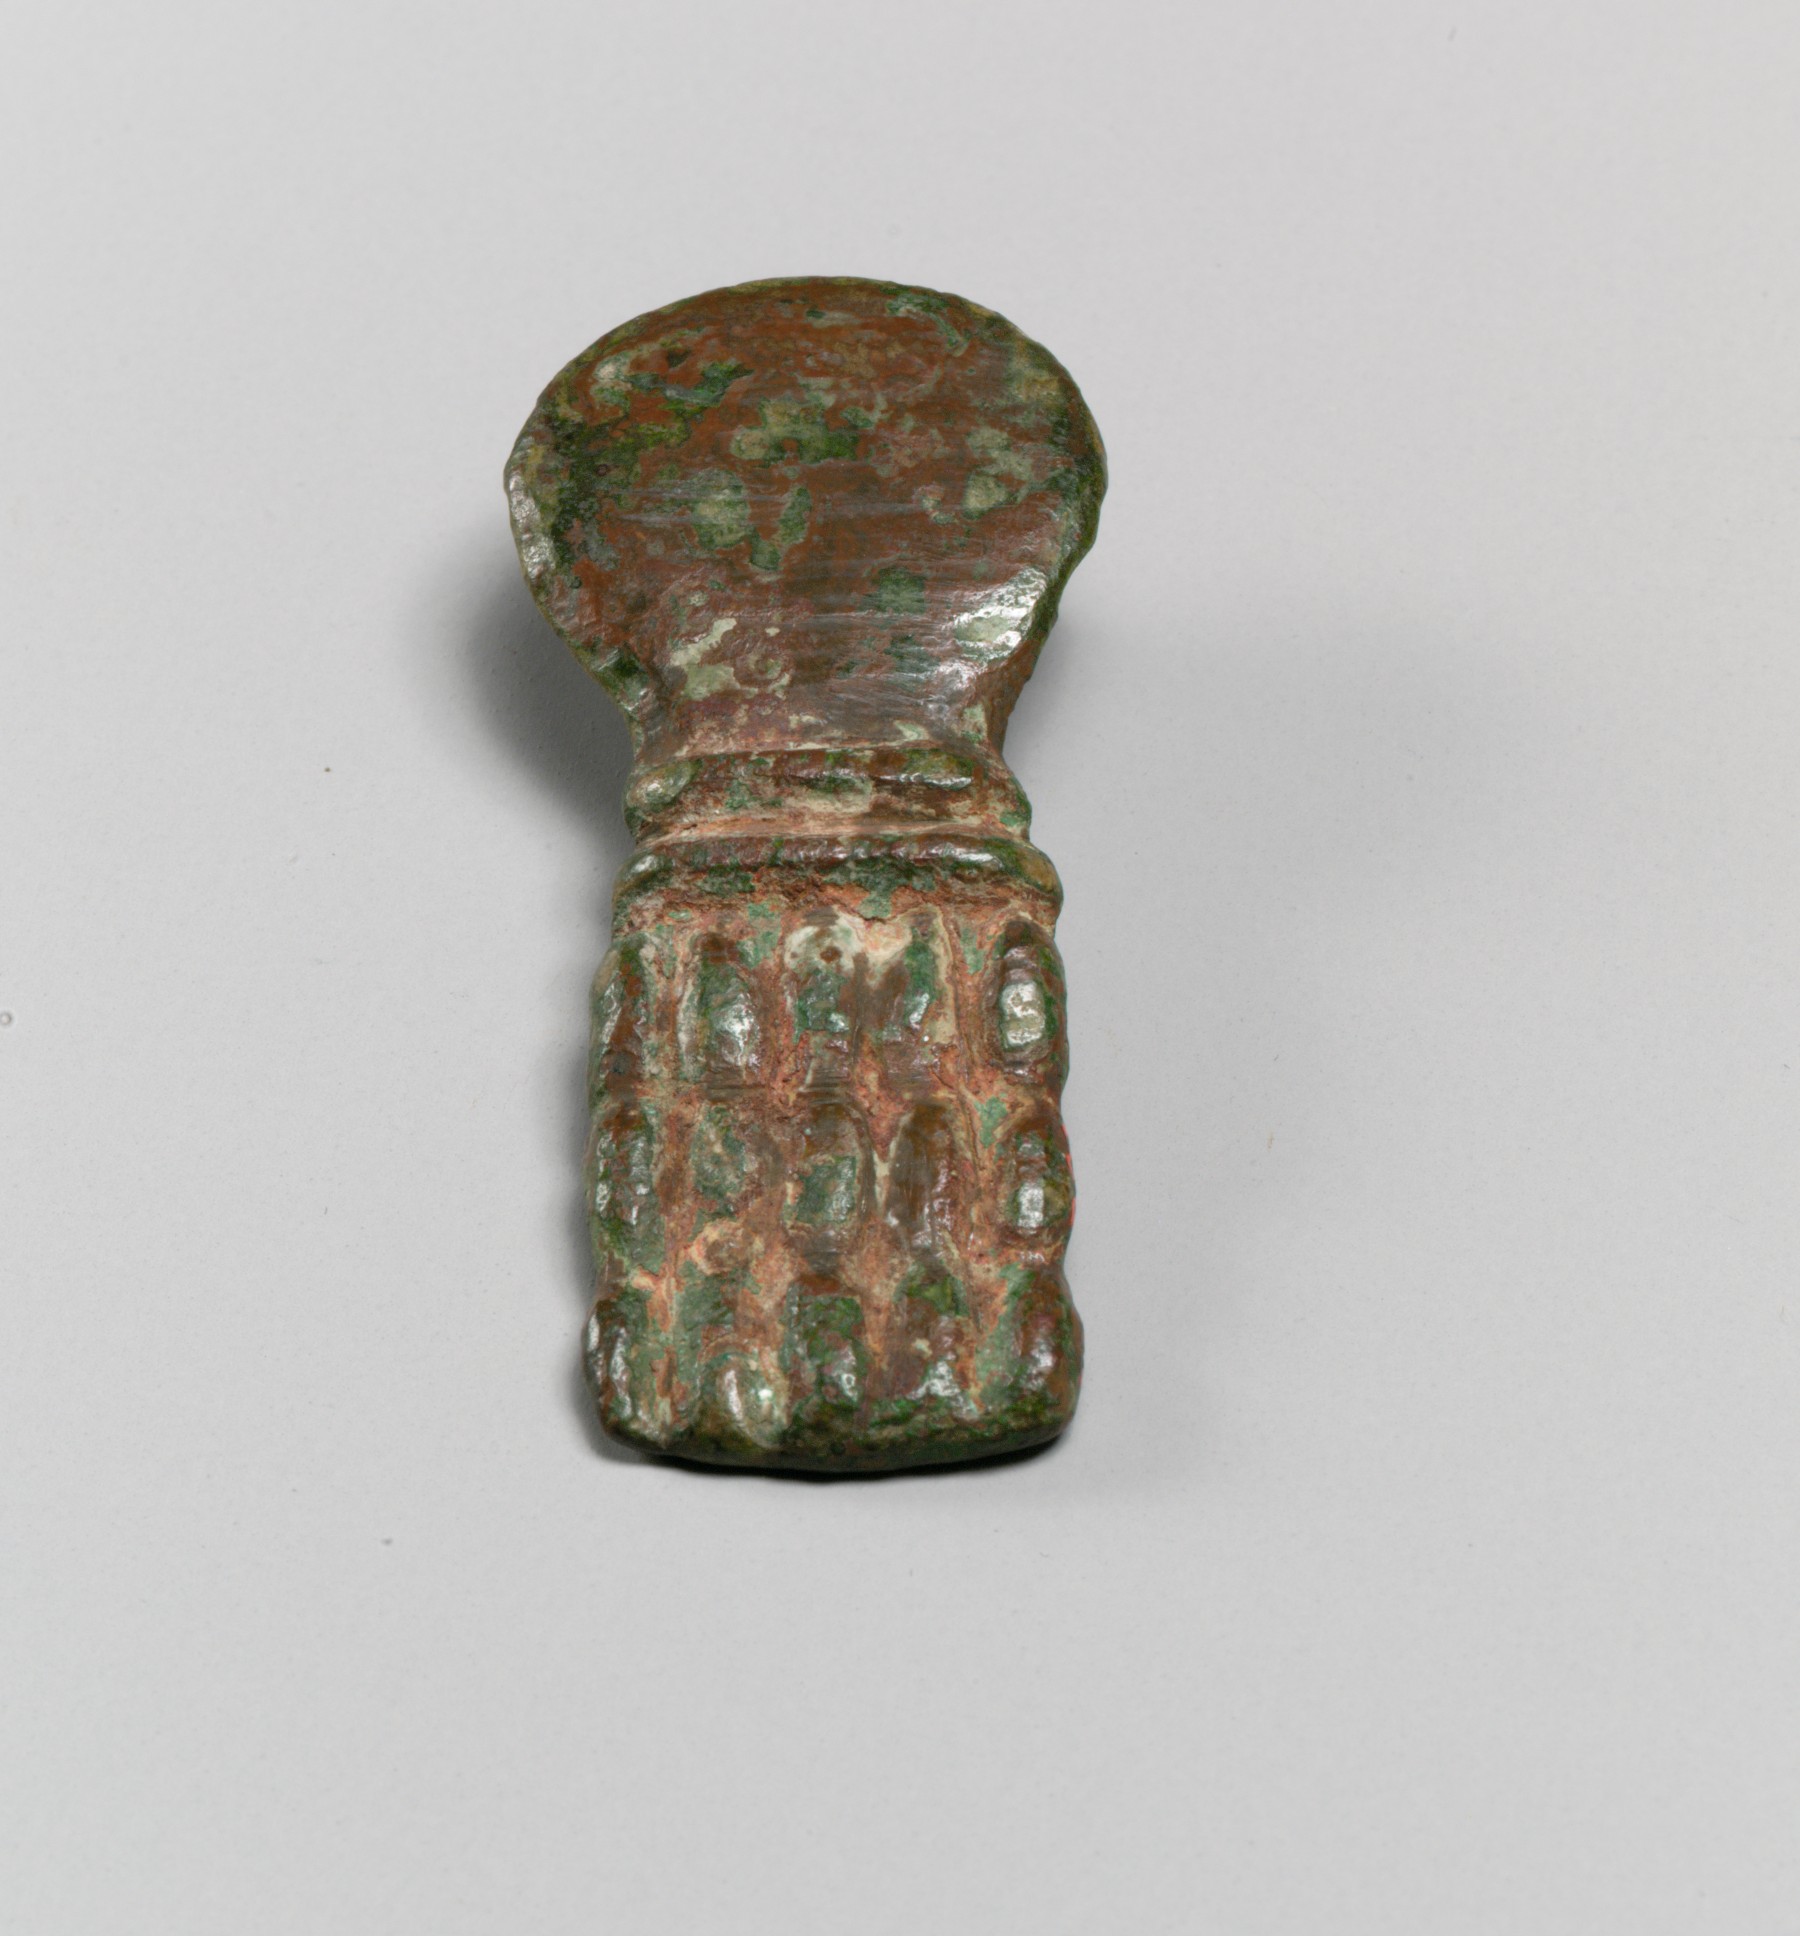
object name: ornament tassel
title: Ornament ? Tassel ?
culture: roman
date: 1-300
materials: bronze